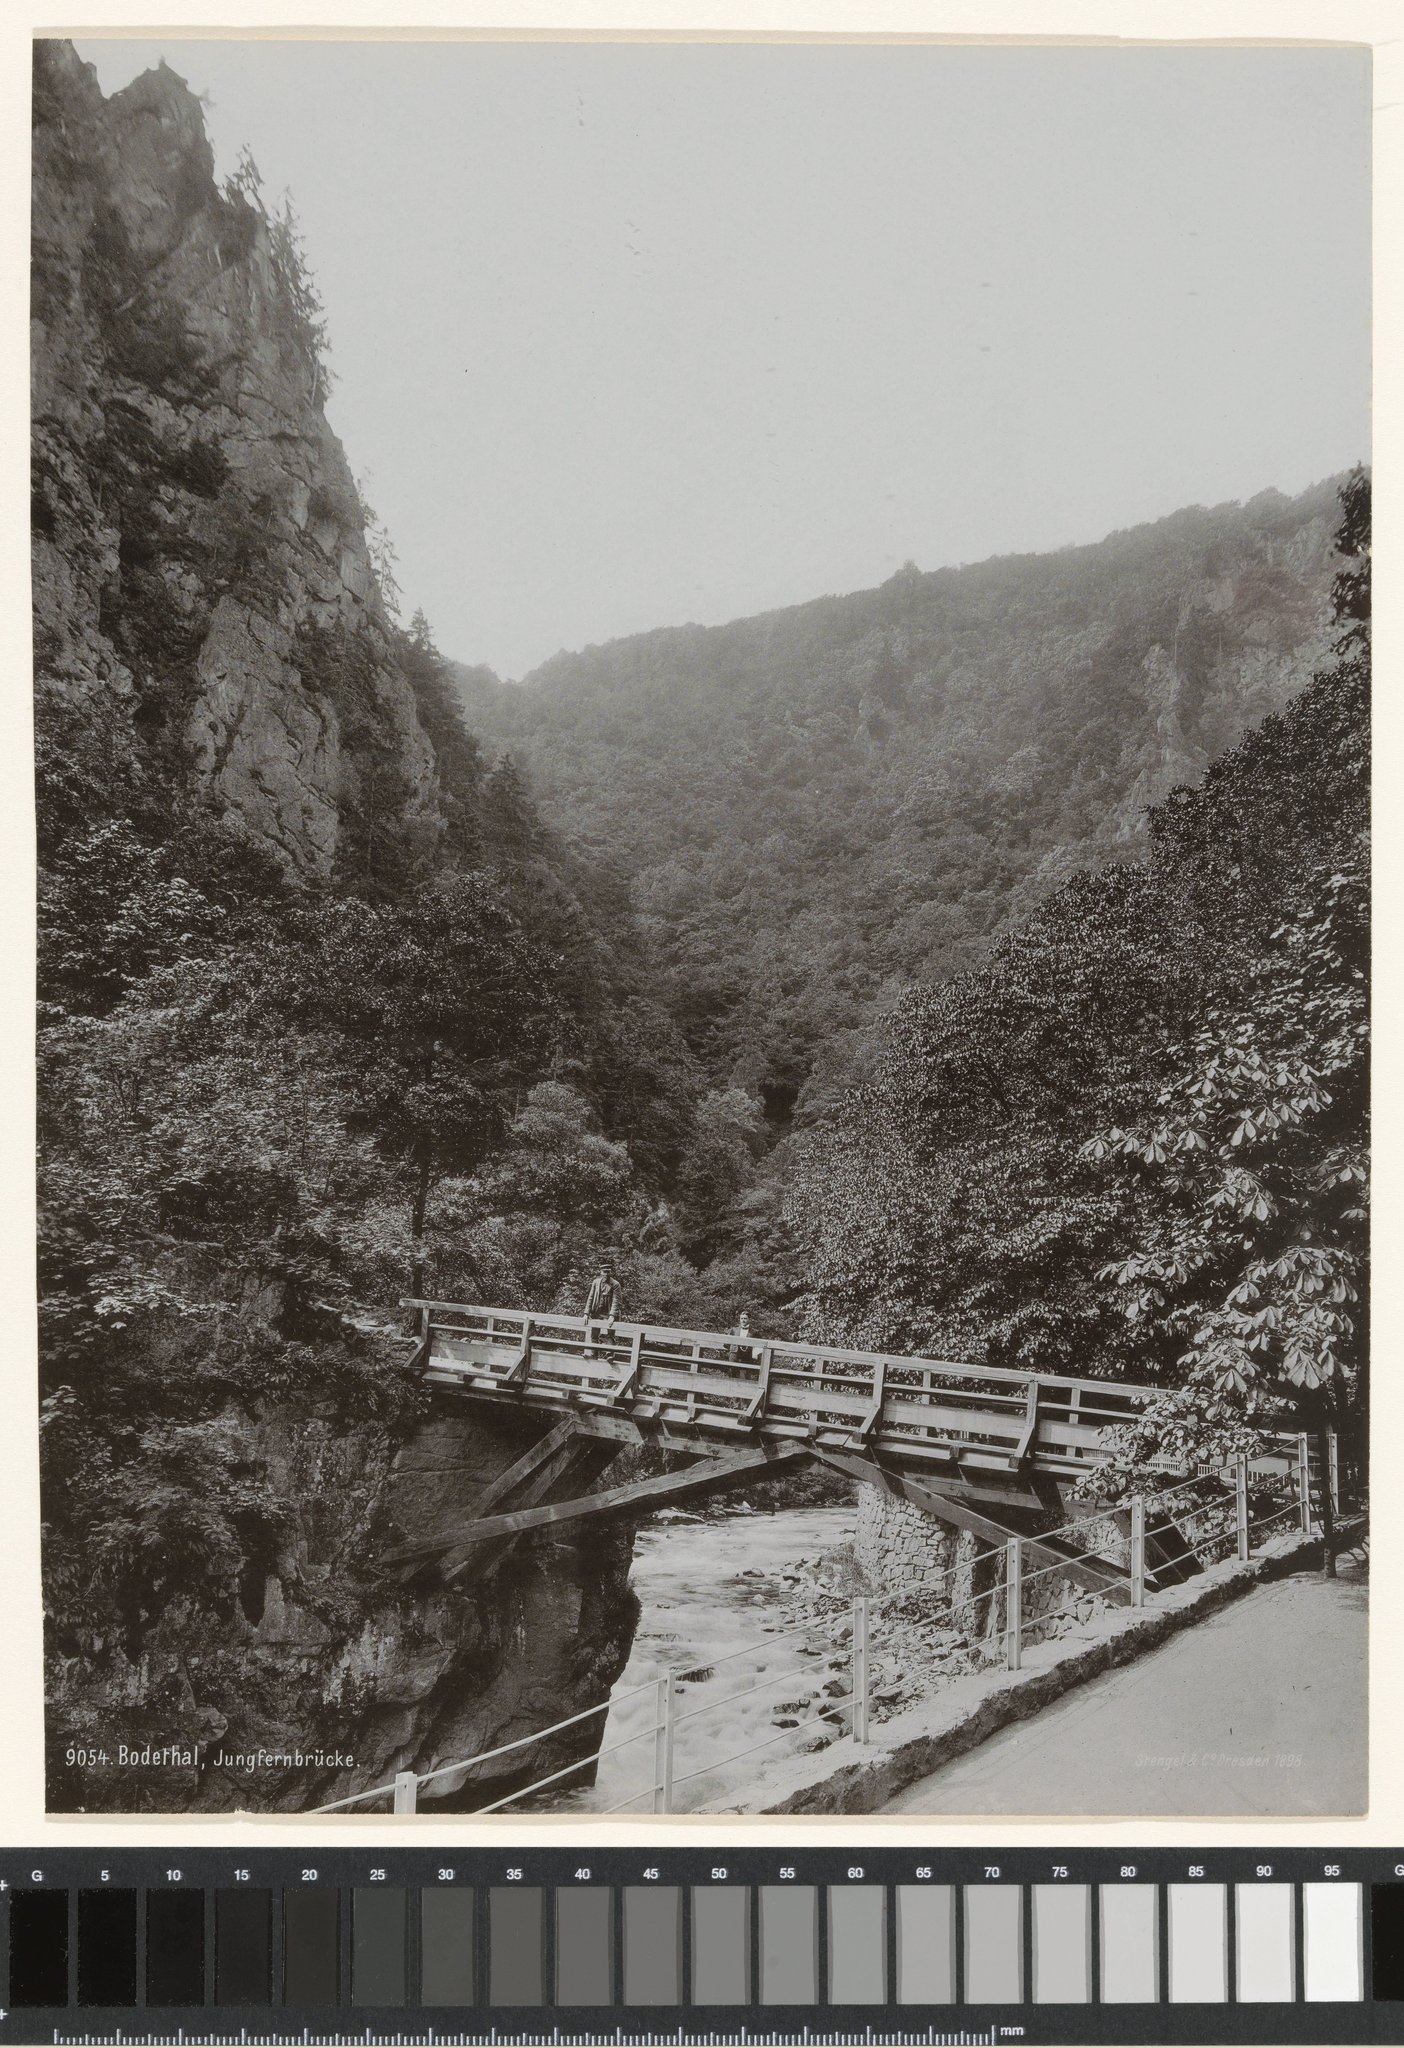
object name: photomechanical print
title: Bodethal, Jungfernbrücke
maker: Anonymous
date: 1898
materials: paper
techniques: photograph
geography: dresden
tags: dale, valley, river, bridge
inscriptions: title: ‘9054. Bodethal, Jungfernbrücke. Stengel & Co. Dresden 1898’